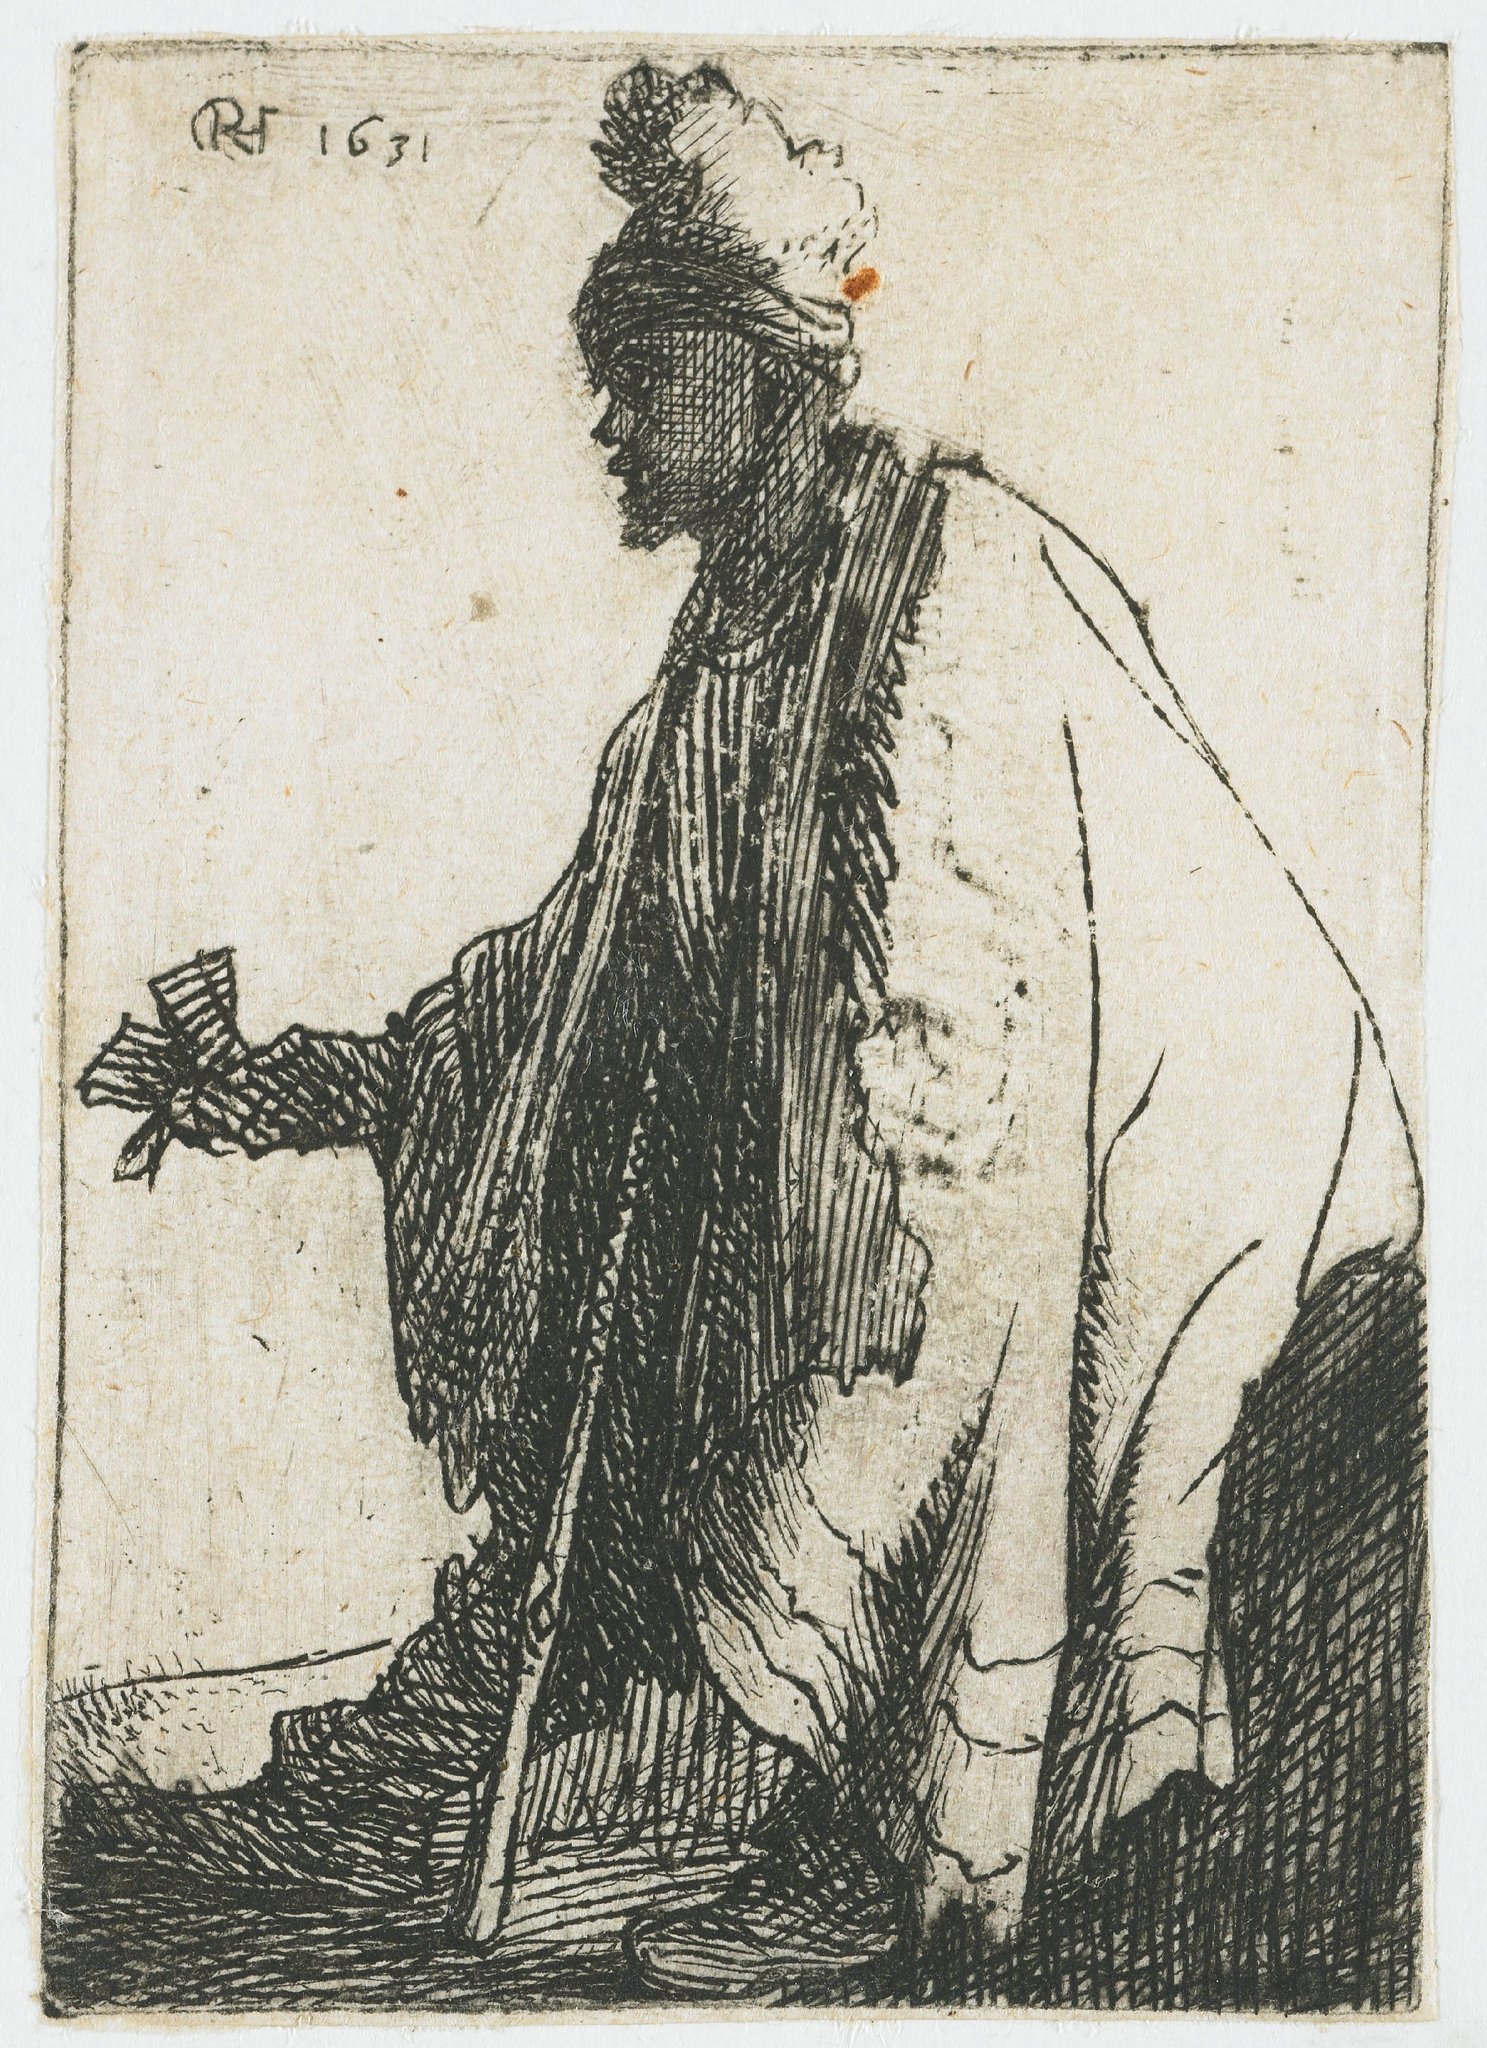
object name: print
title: The Leper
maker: rembrandt van rijn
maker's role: draughtsman, painter, print maker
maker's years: 1606-1669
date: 1629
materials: paper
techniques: etching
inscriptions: monogram and date: ‘RHL 1631’, collector's mark: Lugt 240